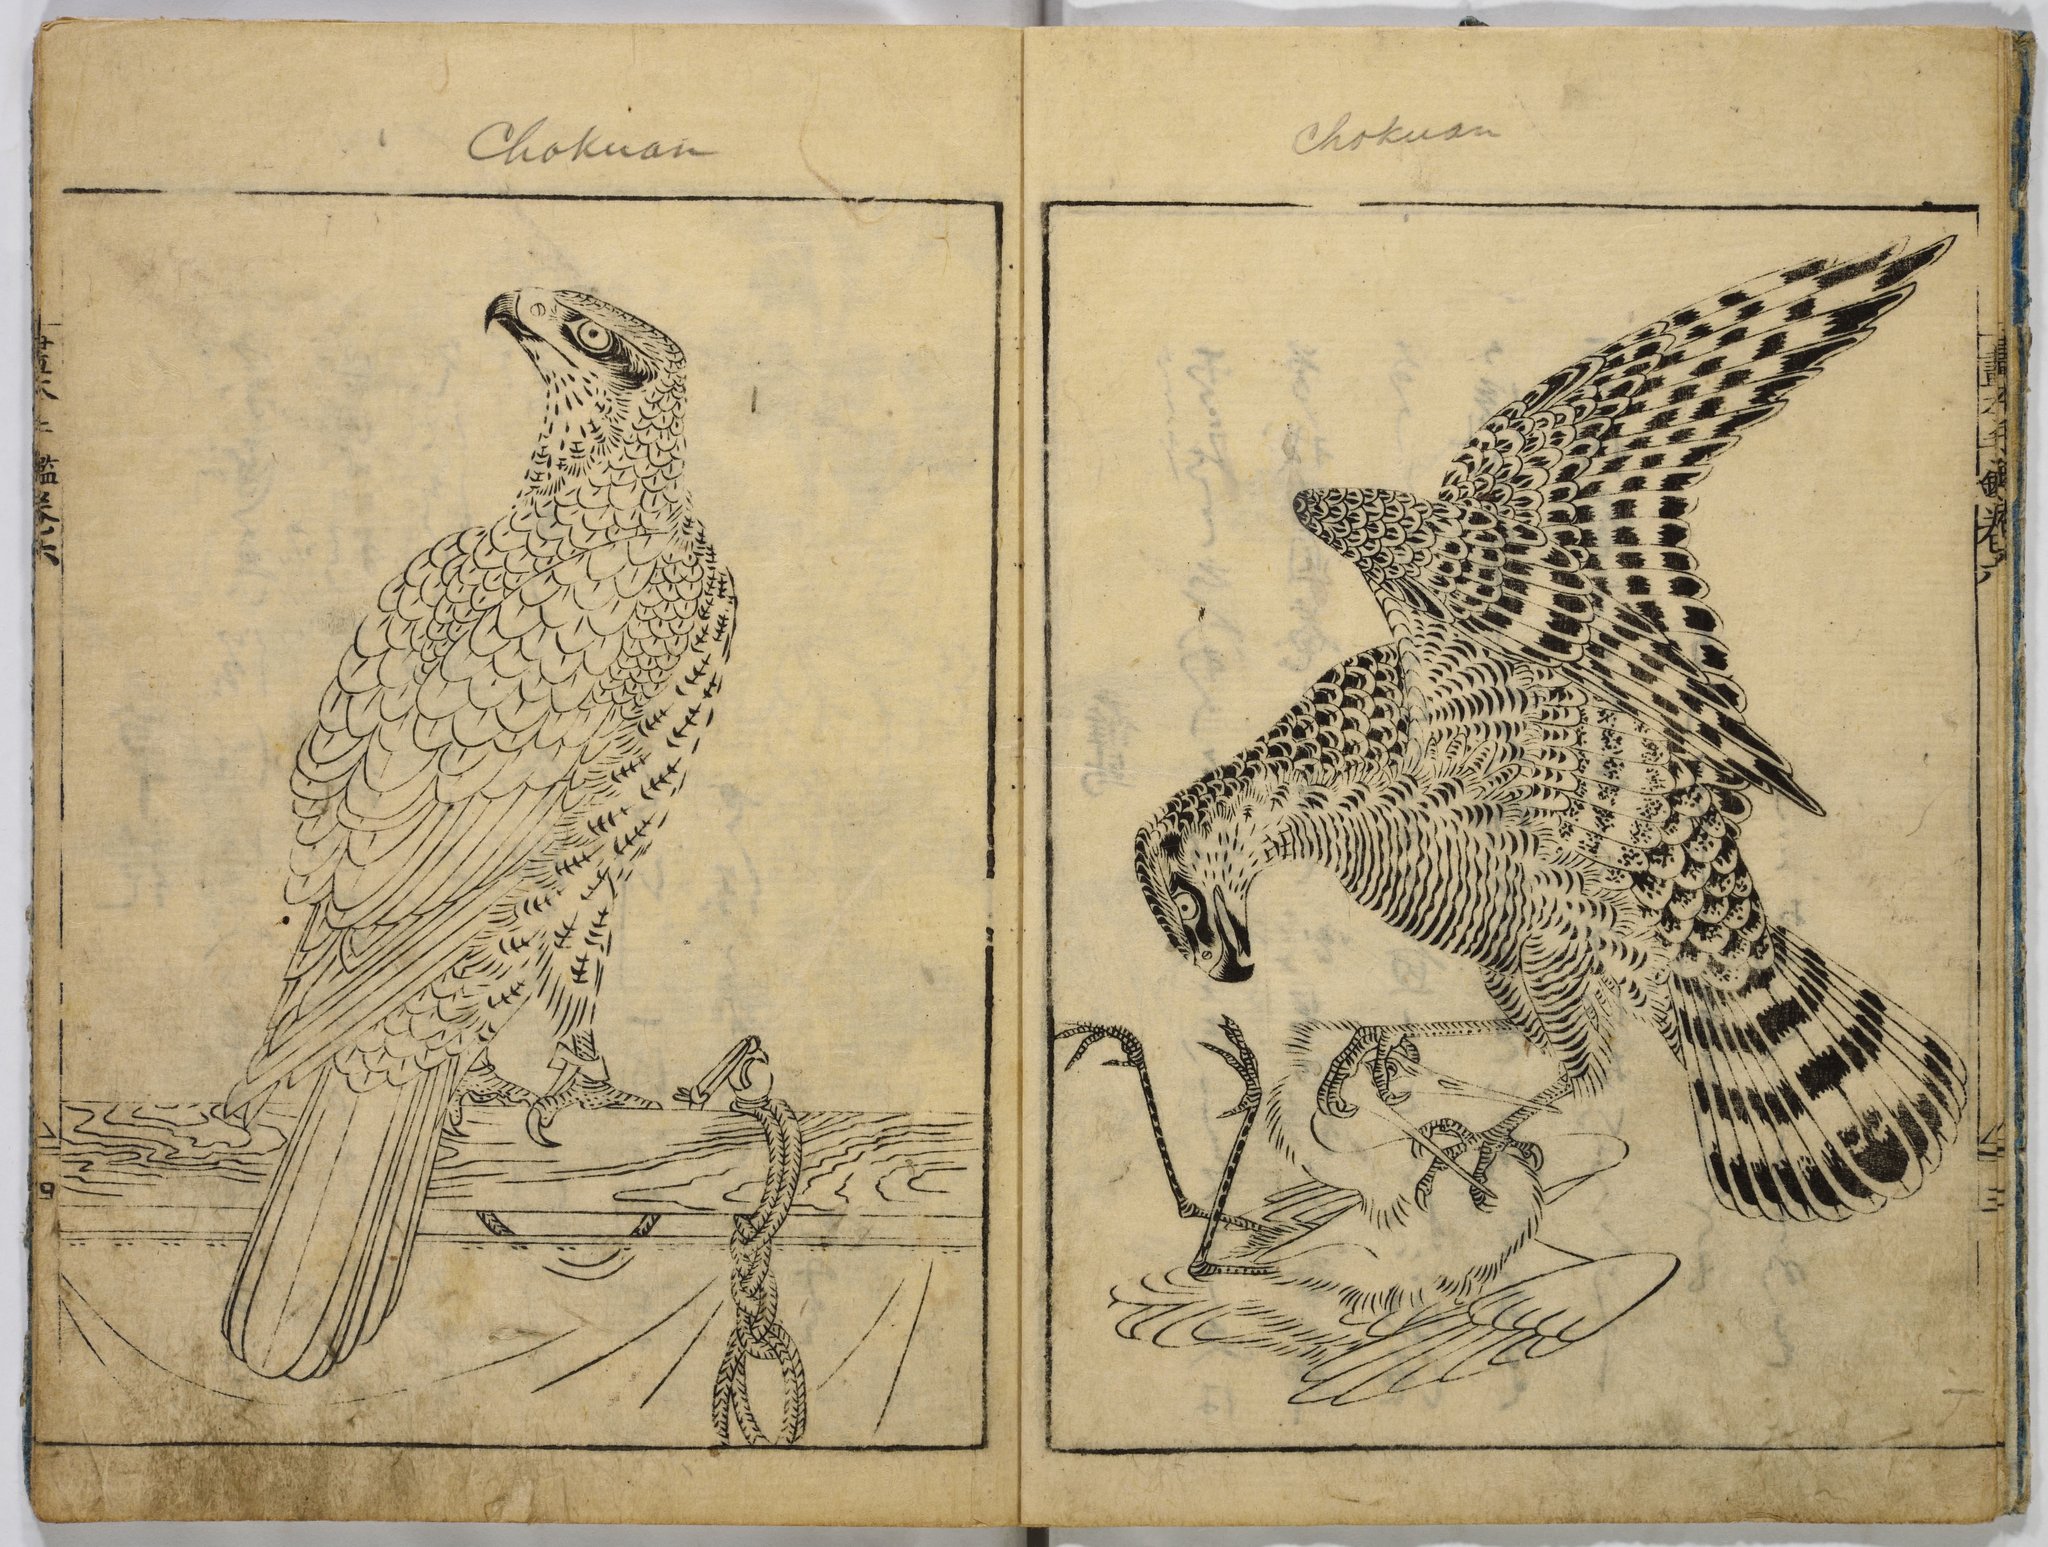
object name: illustrated book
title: Book of Famous Japanese and Chinese Paintings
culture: japanese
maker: ooka shunboku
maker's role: artist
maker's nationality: japanese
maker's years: 1680-1763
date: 1720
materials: ink, paper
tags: eagles